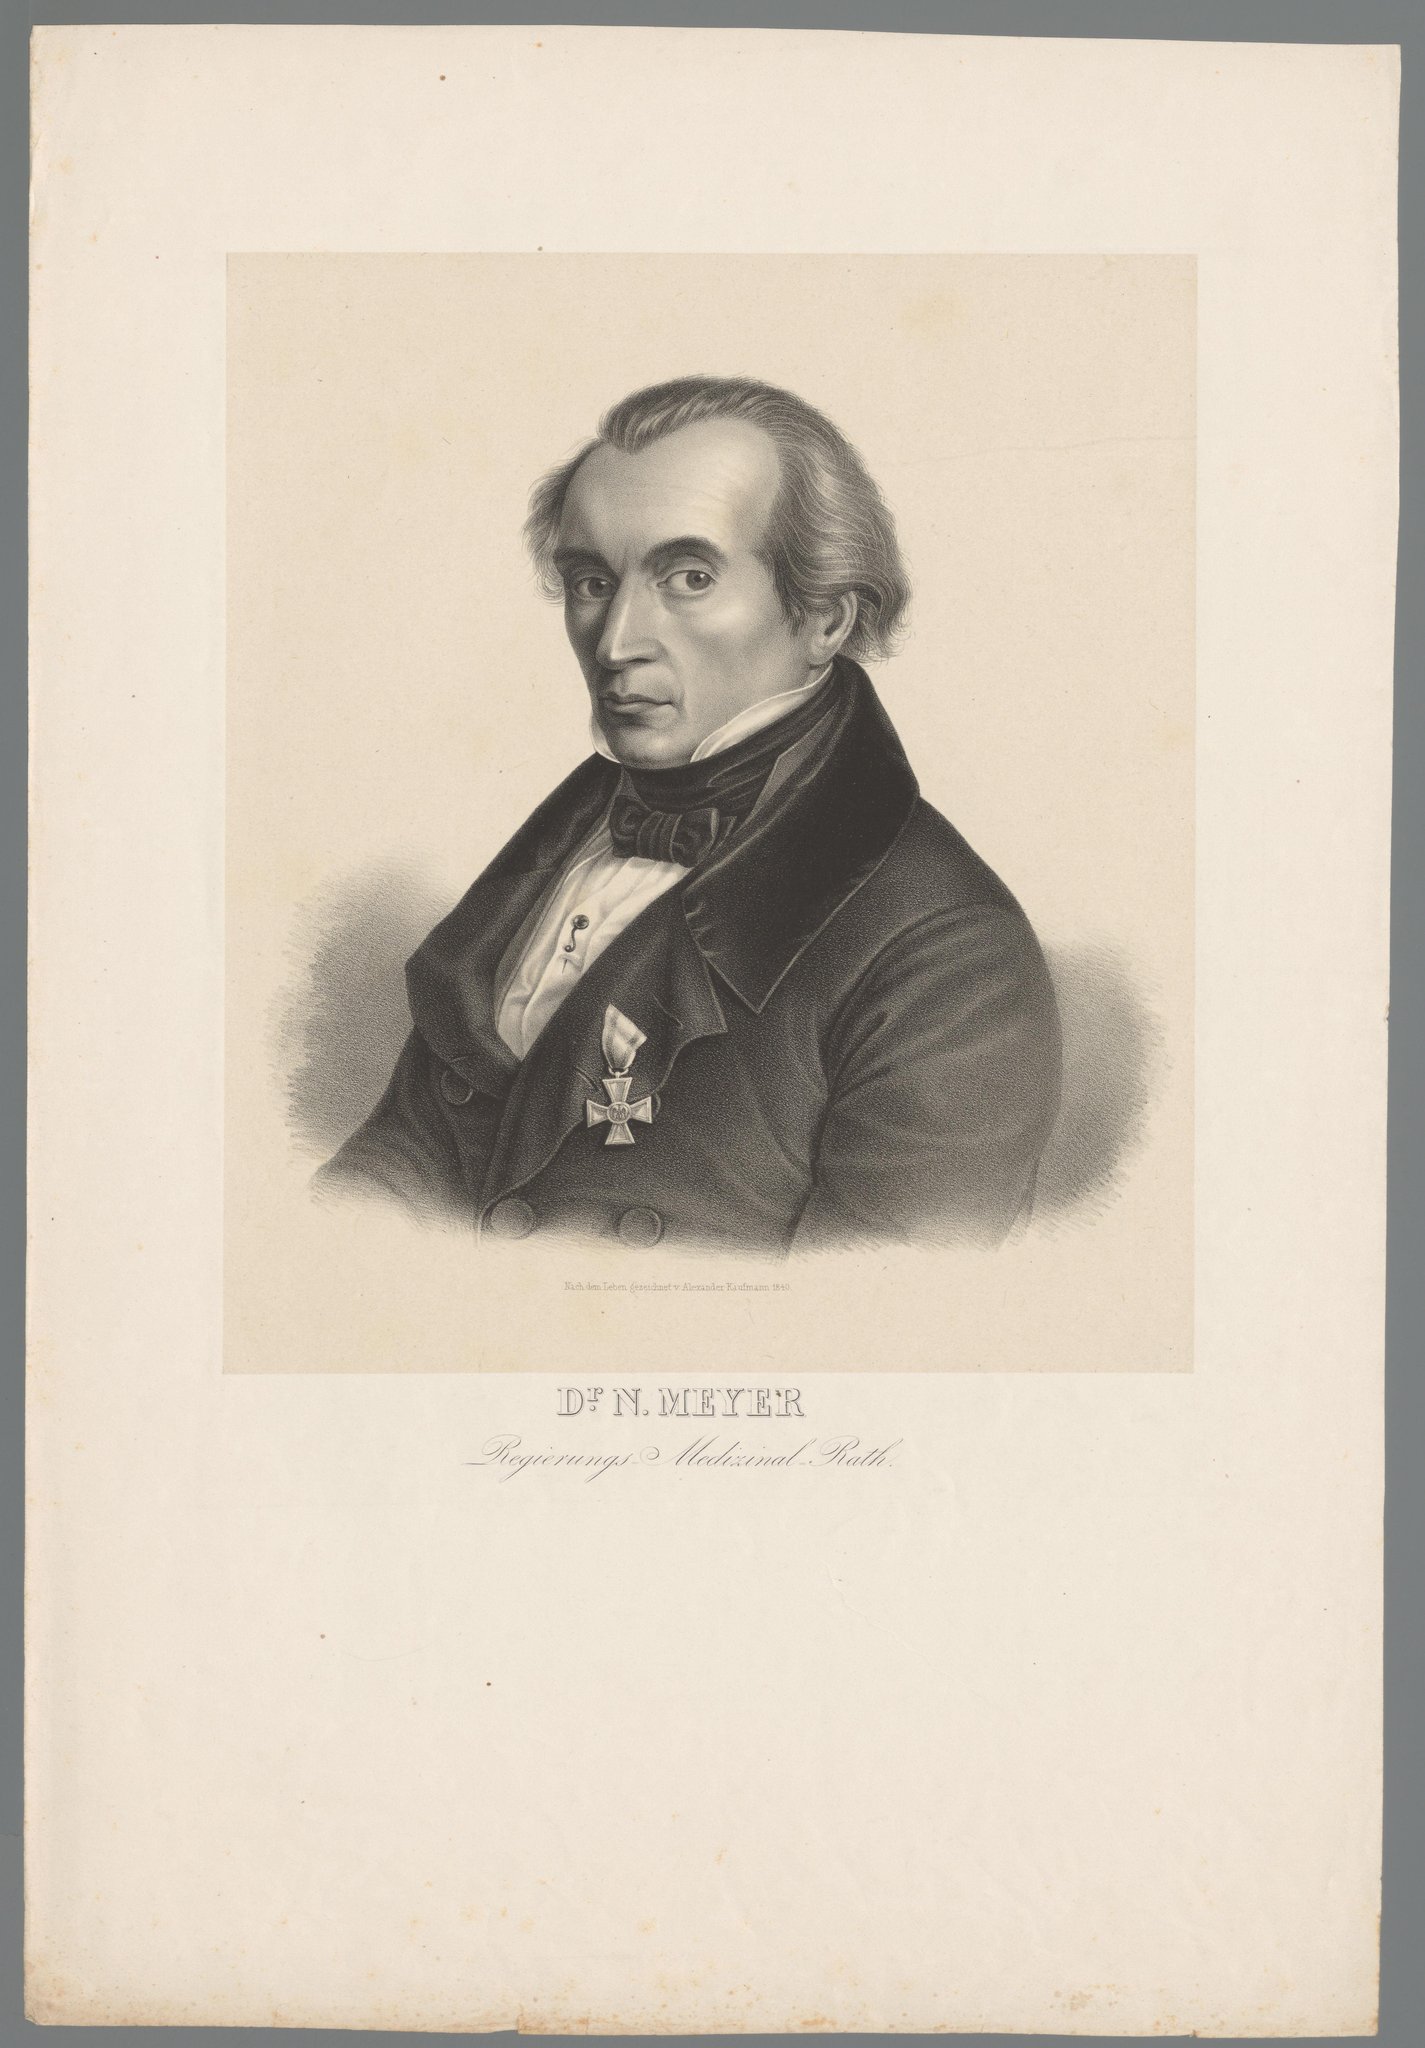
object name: print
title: Portret van N. Meyer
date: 1840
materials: paper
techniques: lithograph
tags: adult man, historical persons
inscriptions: collector's mark: Lugt 2228